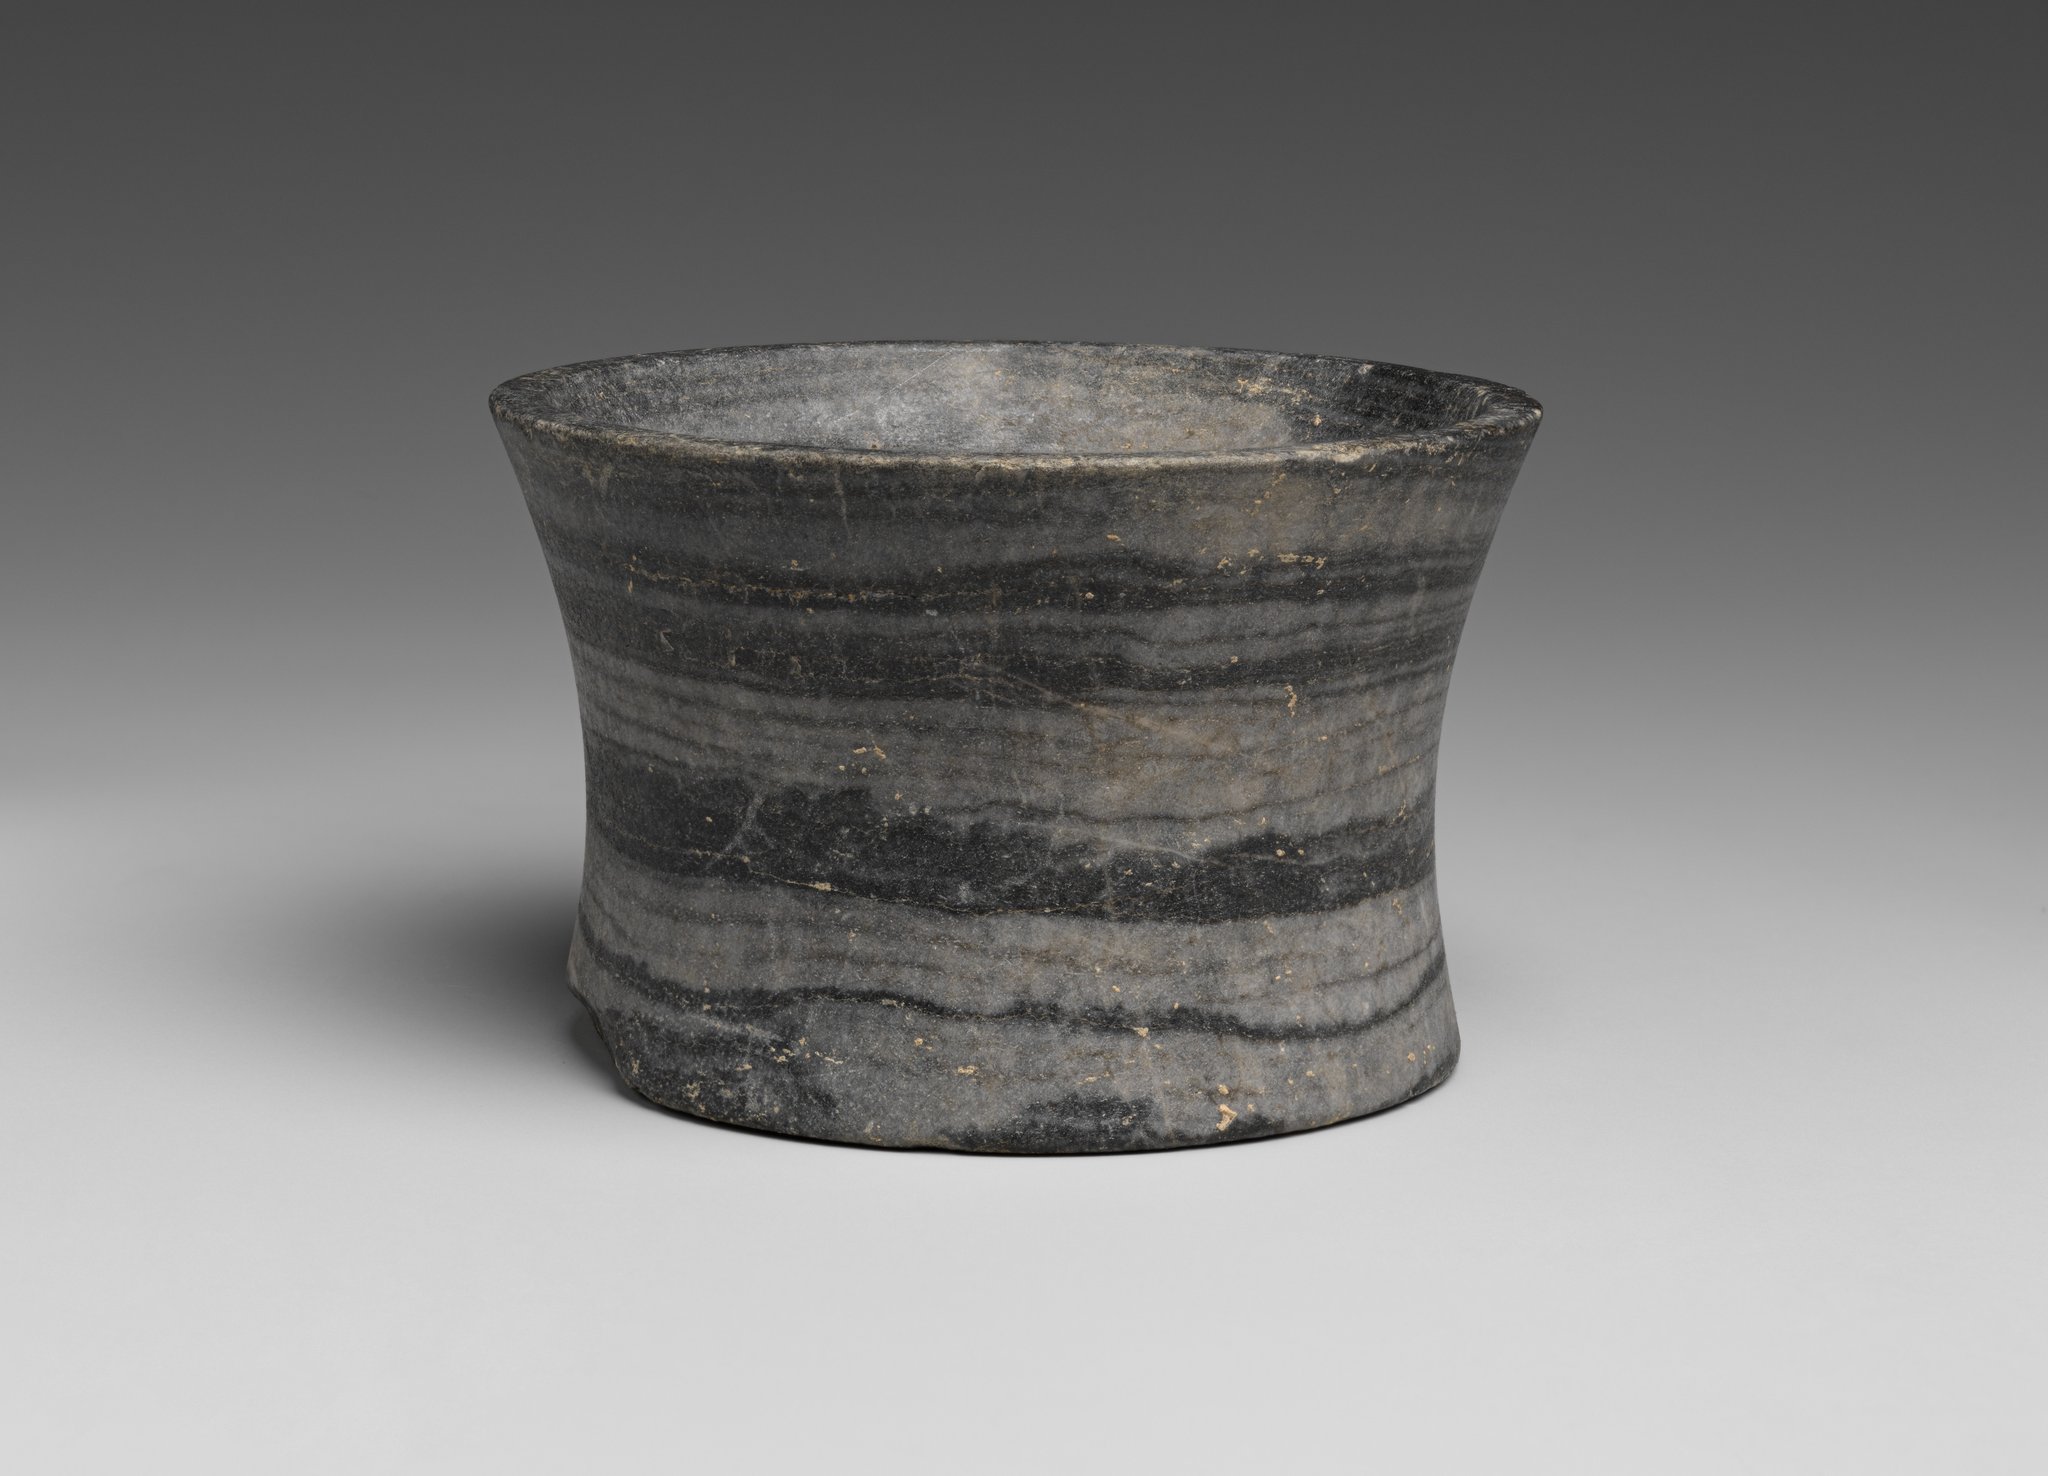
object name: cup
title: Marble handleless cup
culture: minoan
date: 2000-1700 BCE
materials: marble